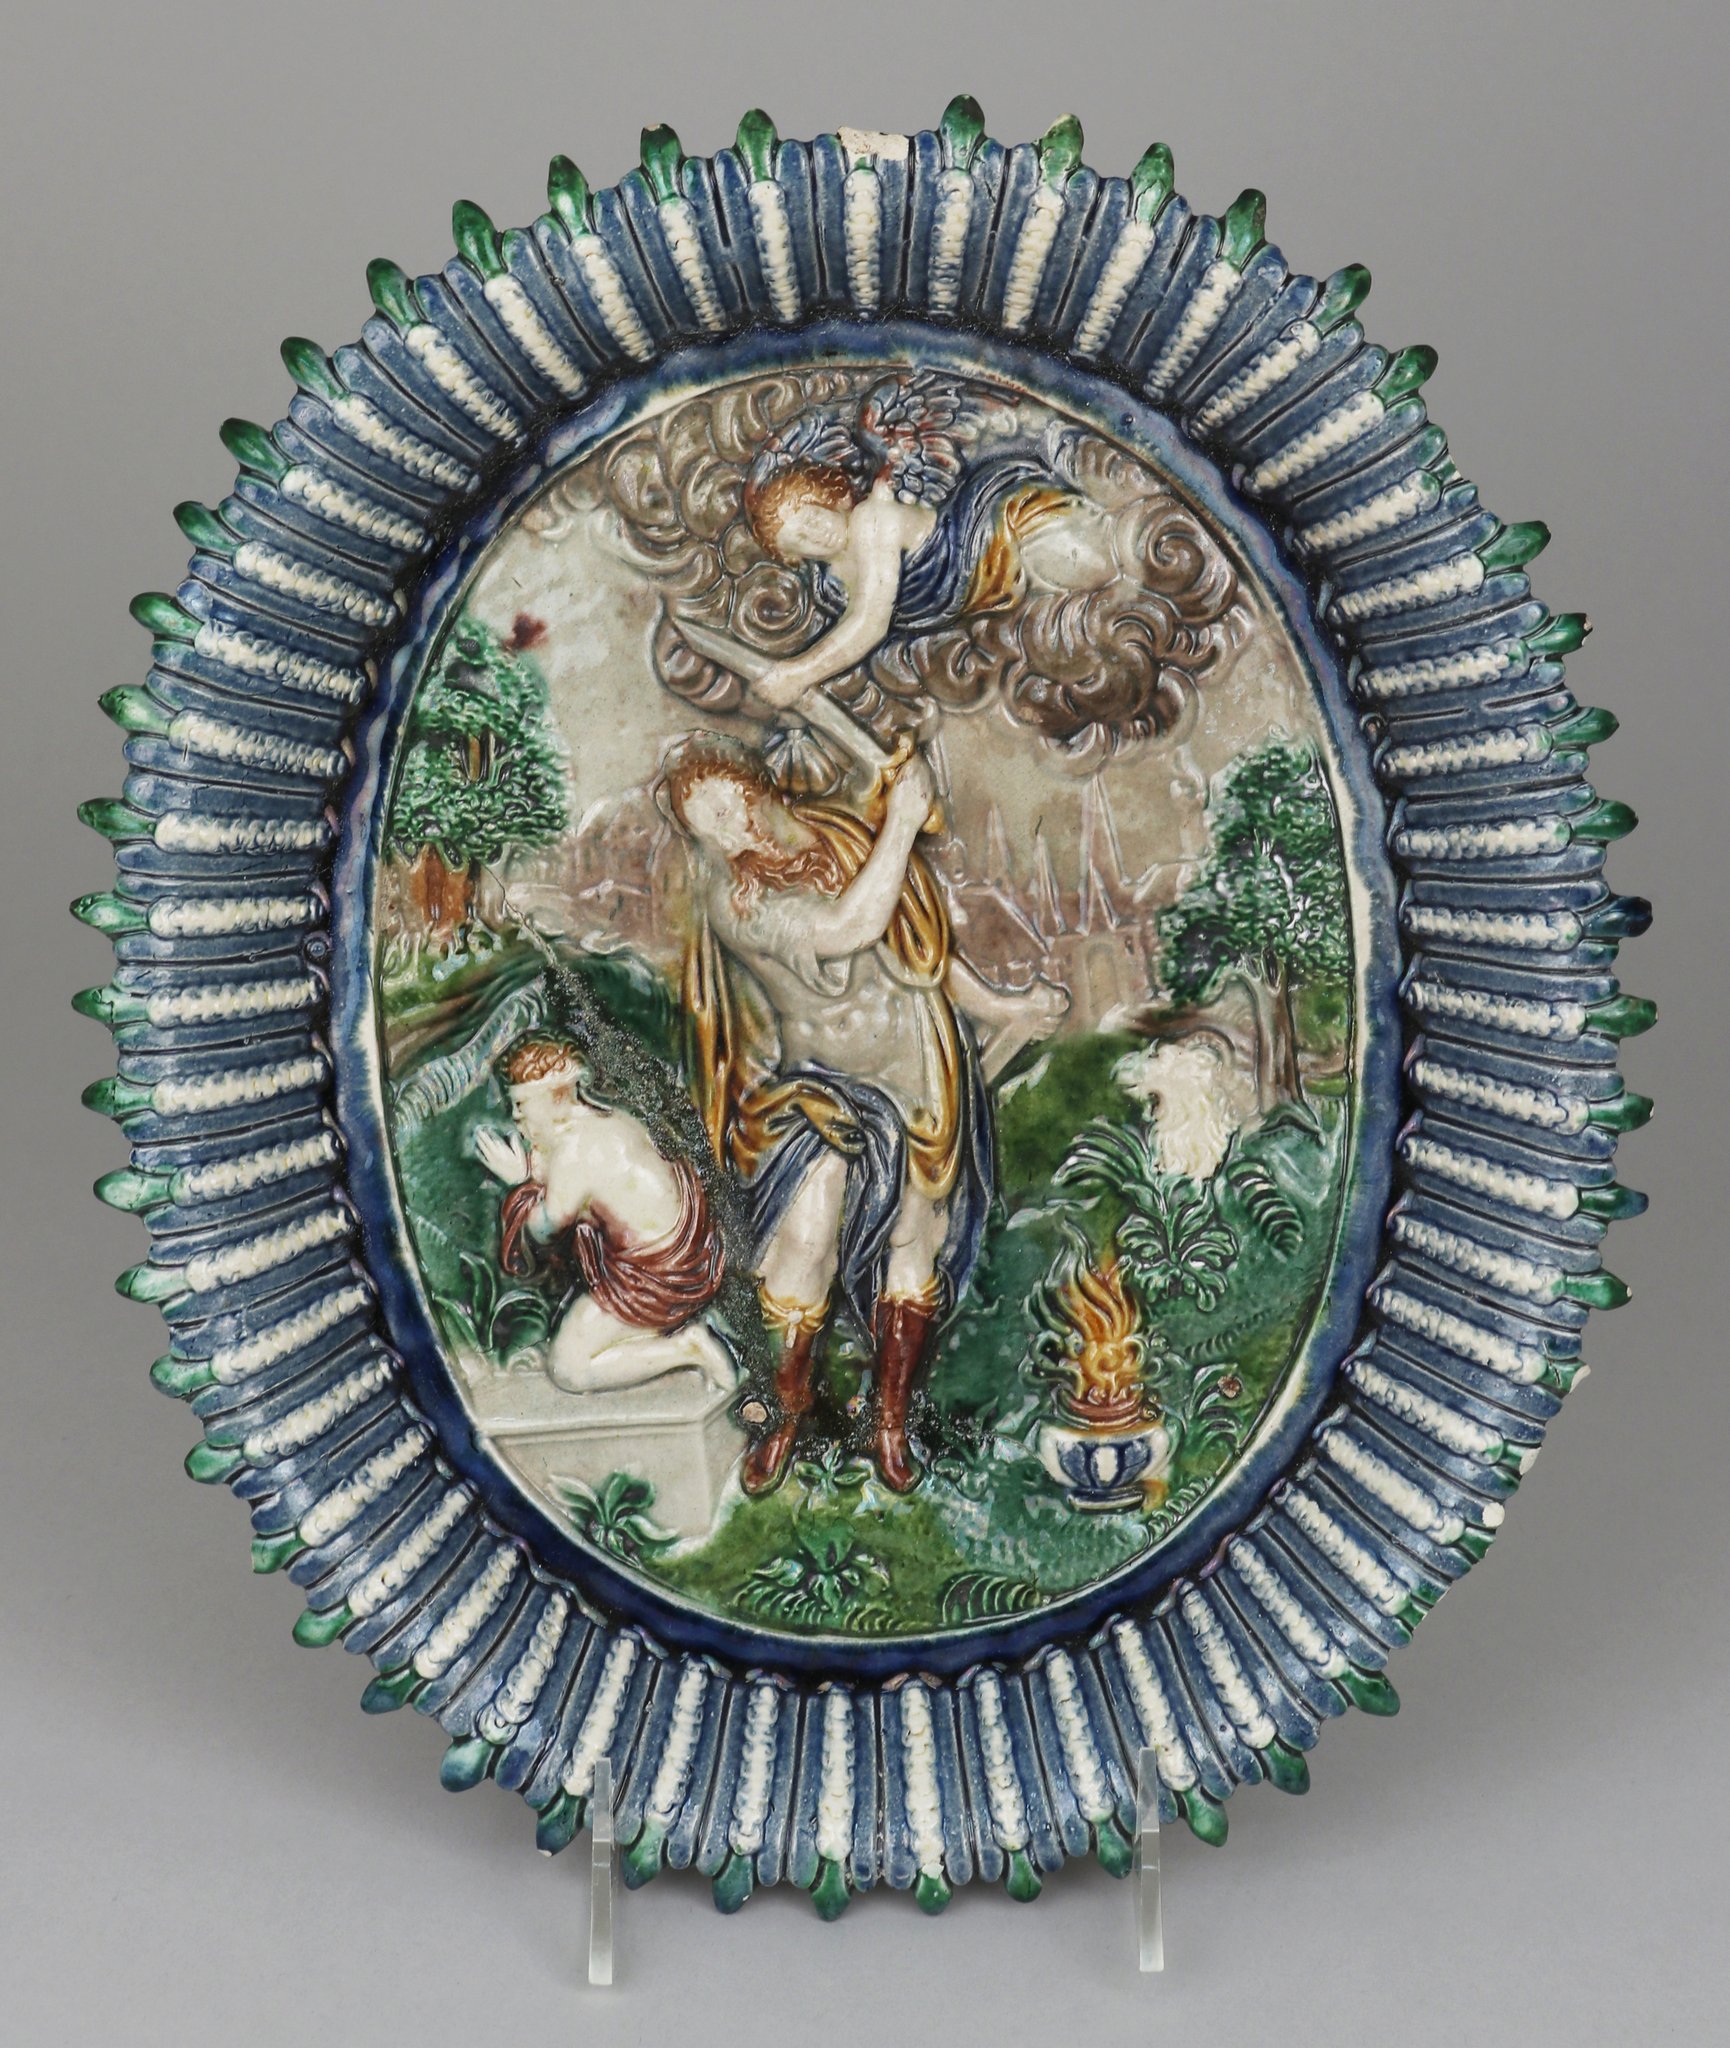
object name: dish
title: Dish with sacrifice of Isaac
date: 1651-1700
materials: earthenware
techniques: glazing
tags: swords,men,angels,isaac